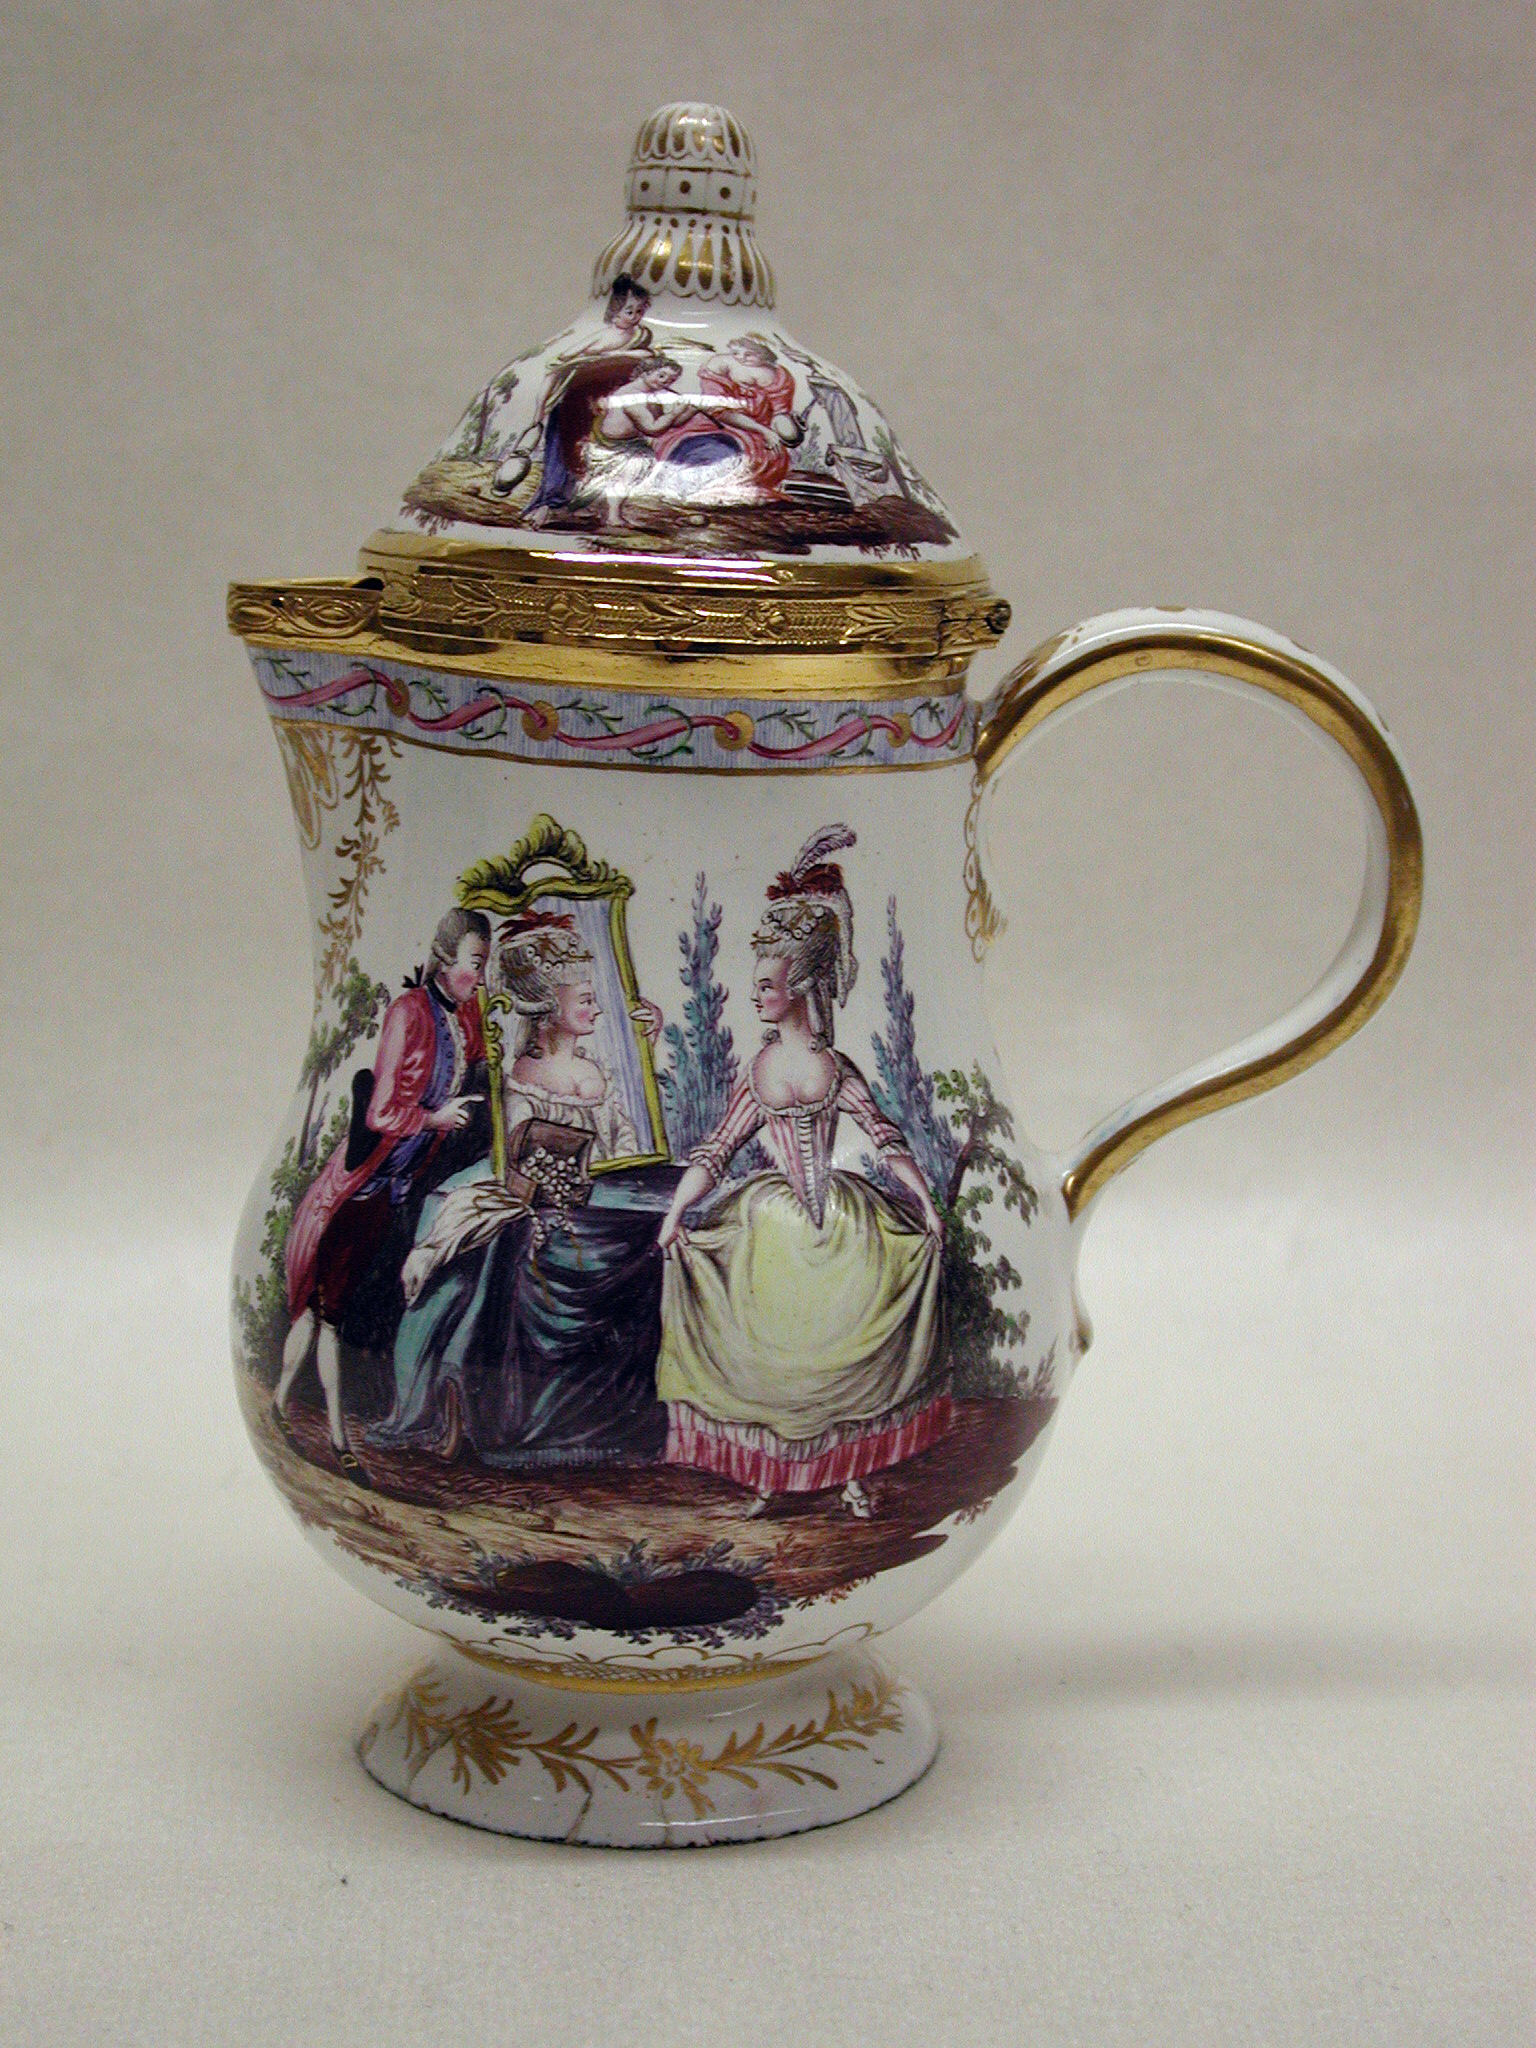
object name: milk jug with cover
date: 1787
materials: copper, enamel, gilt, silver gilt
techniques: painting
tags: children,men,women,dogs,mirrors